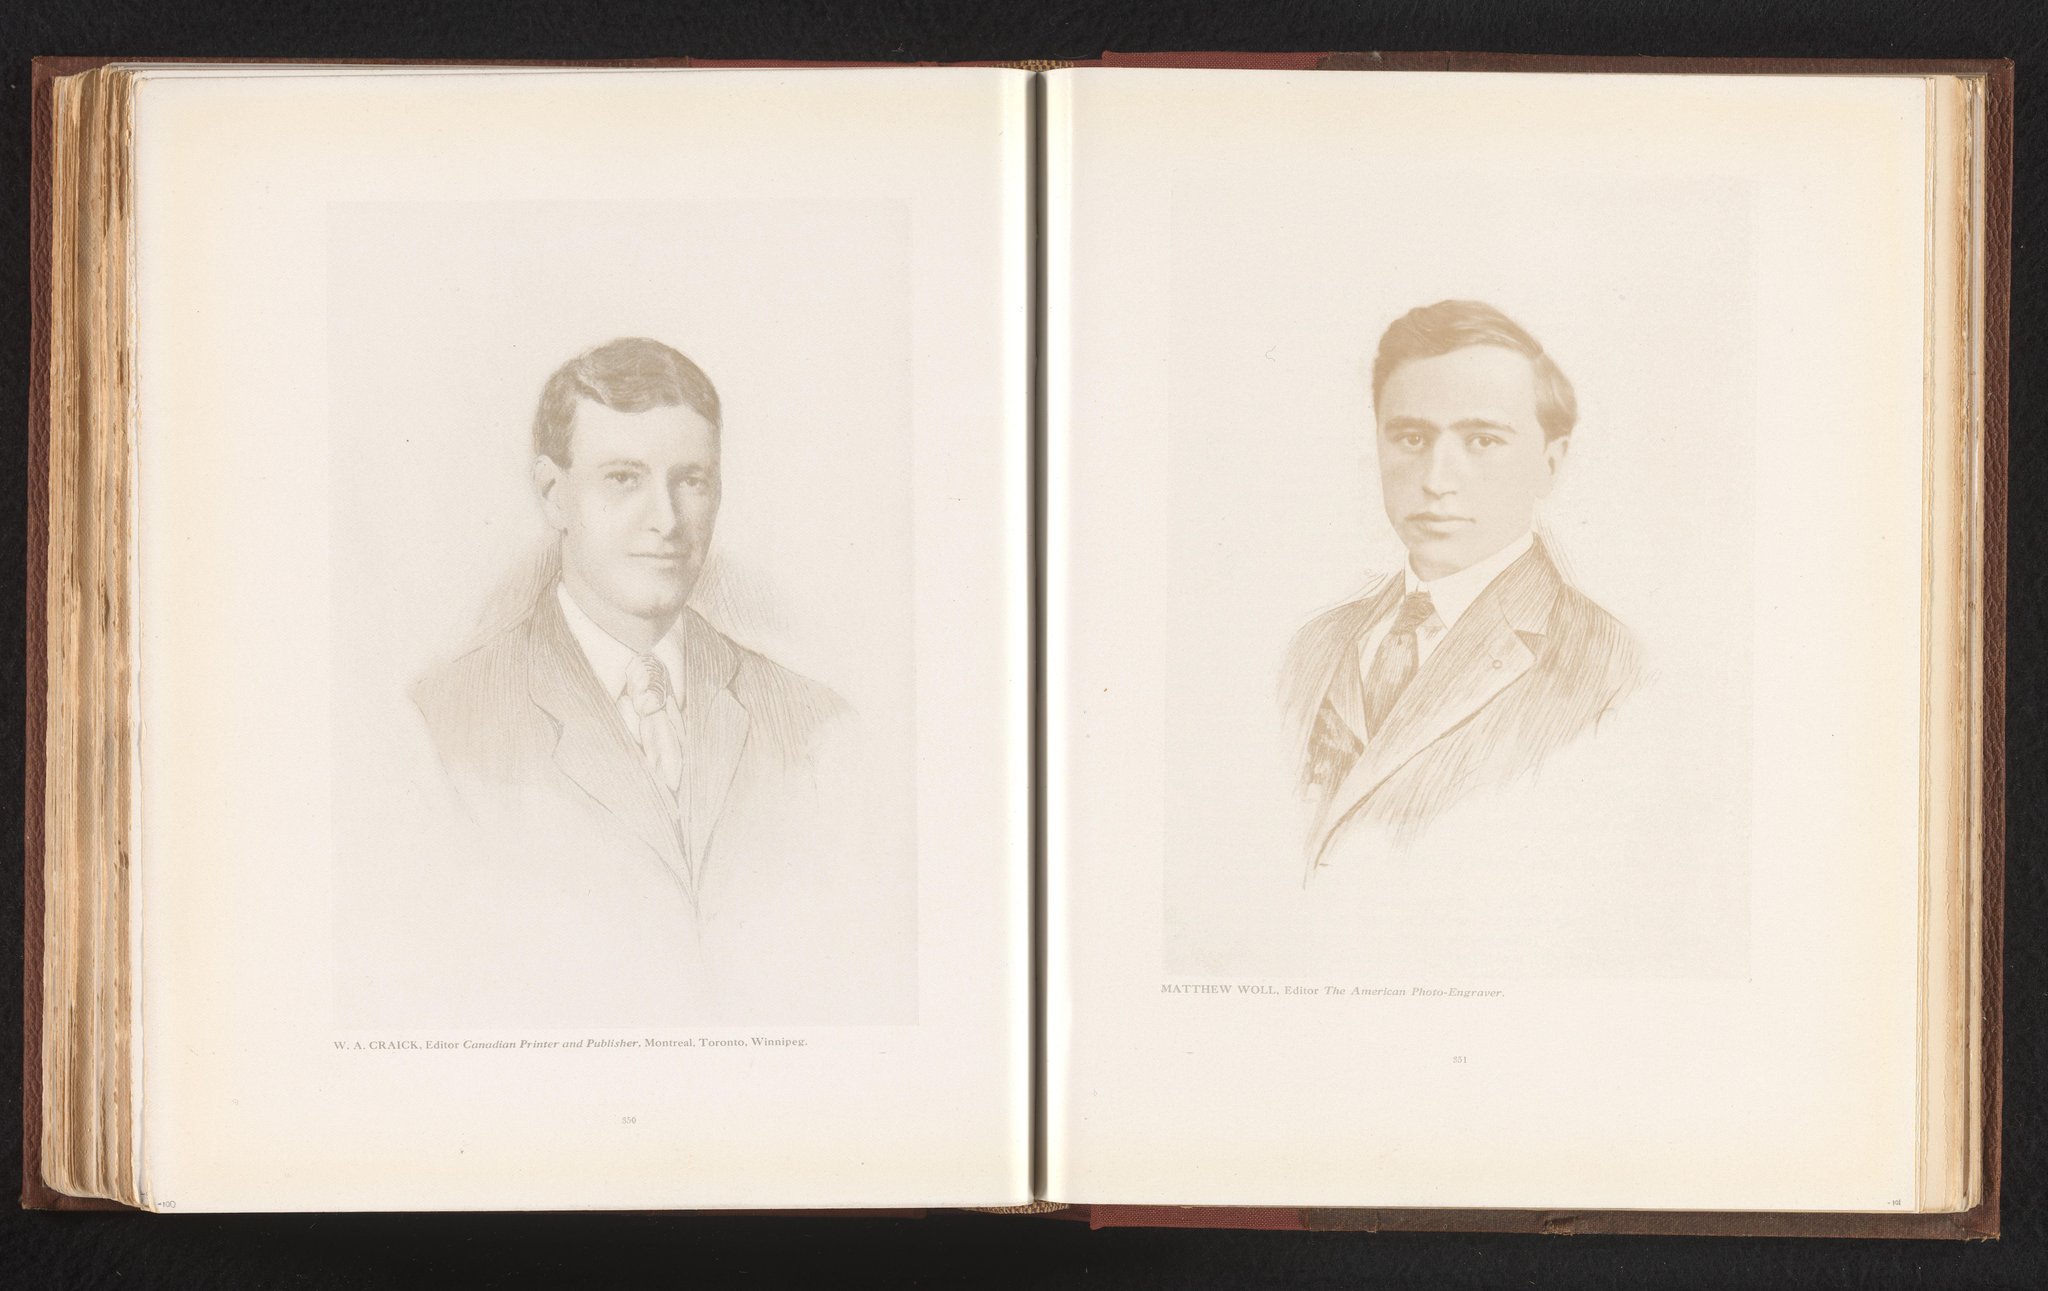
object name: reproduction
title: Reproductie van een geretoucheerde fotoreproductie met een portret van W. A. Craick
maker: Anonymous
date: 1904-1909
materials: paper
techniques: autotype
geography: columbus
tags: adult man, historical persons